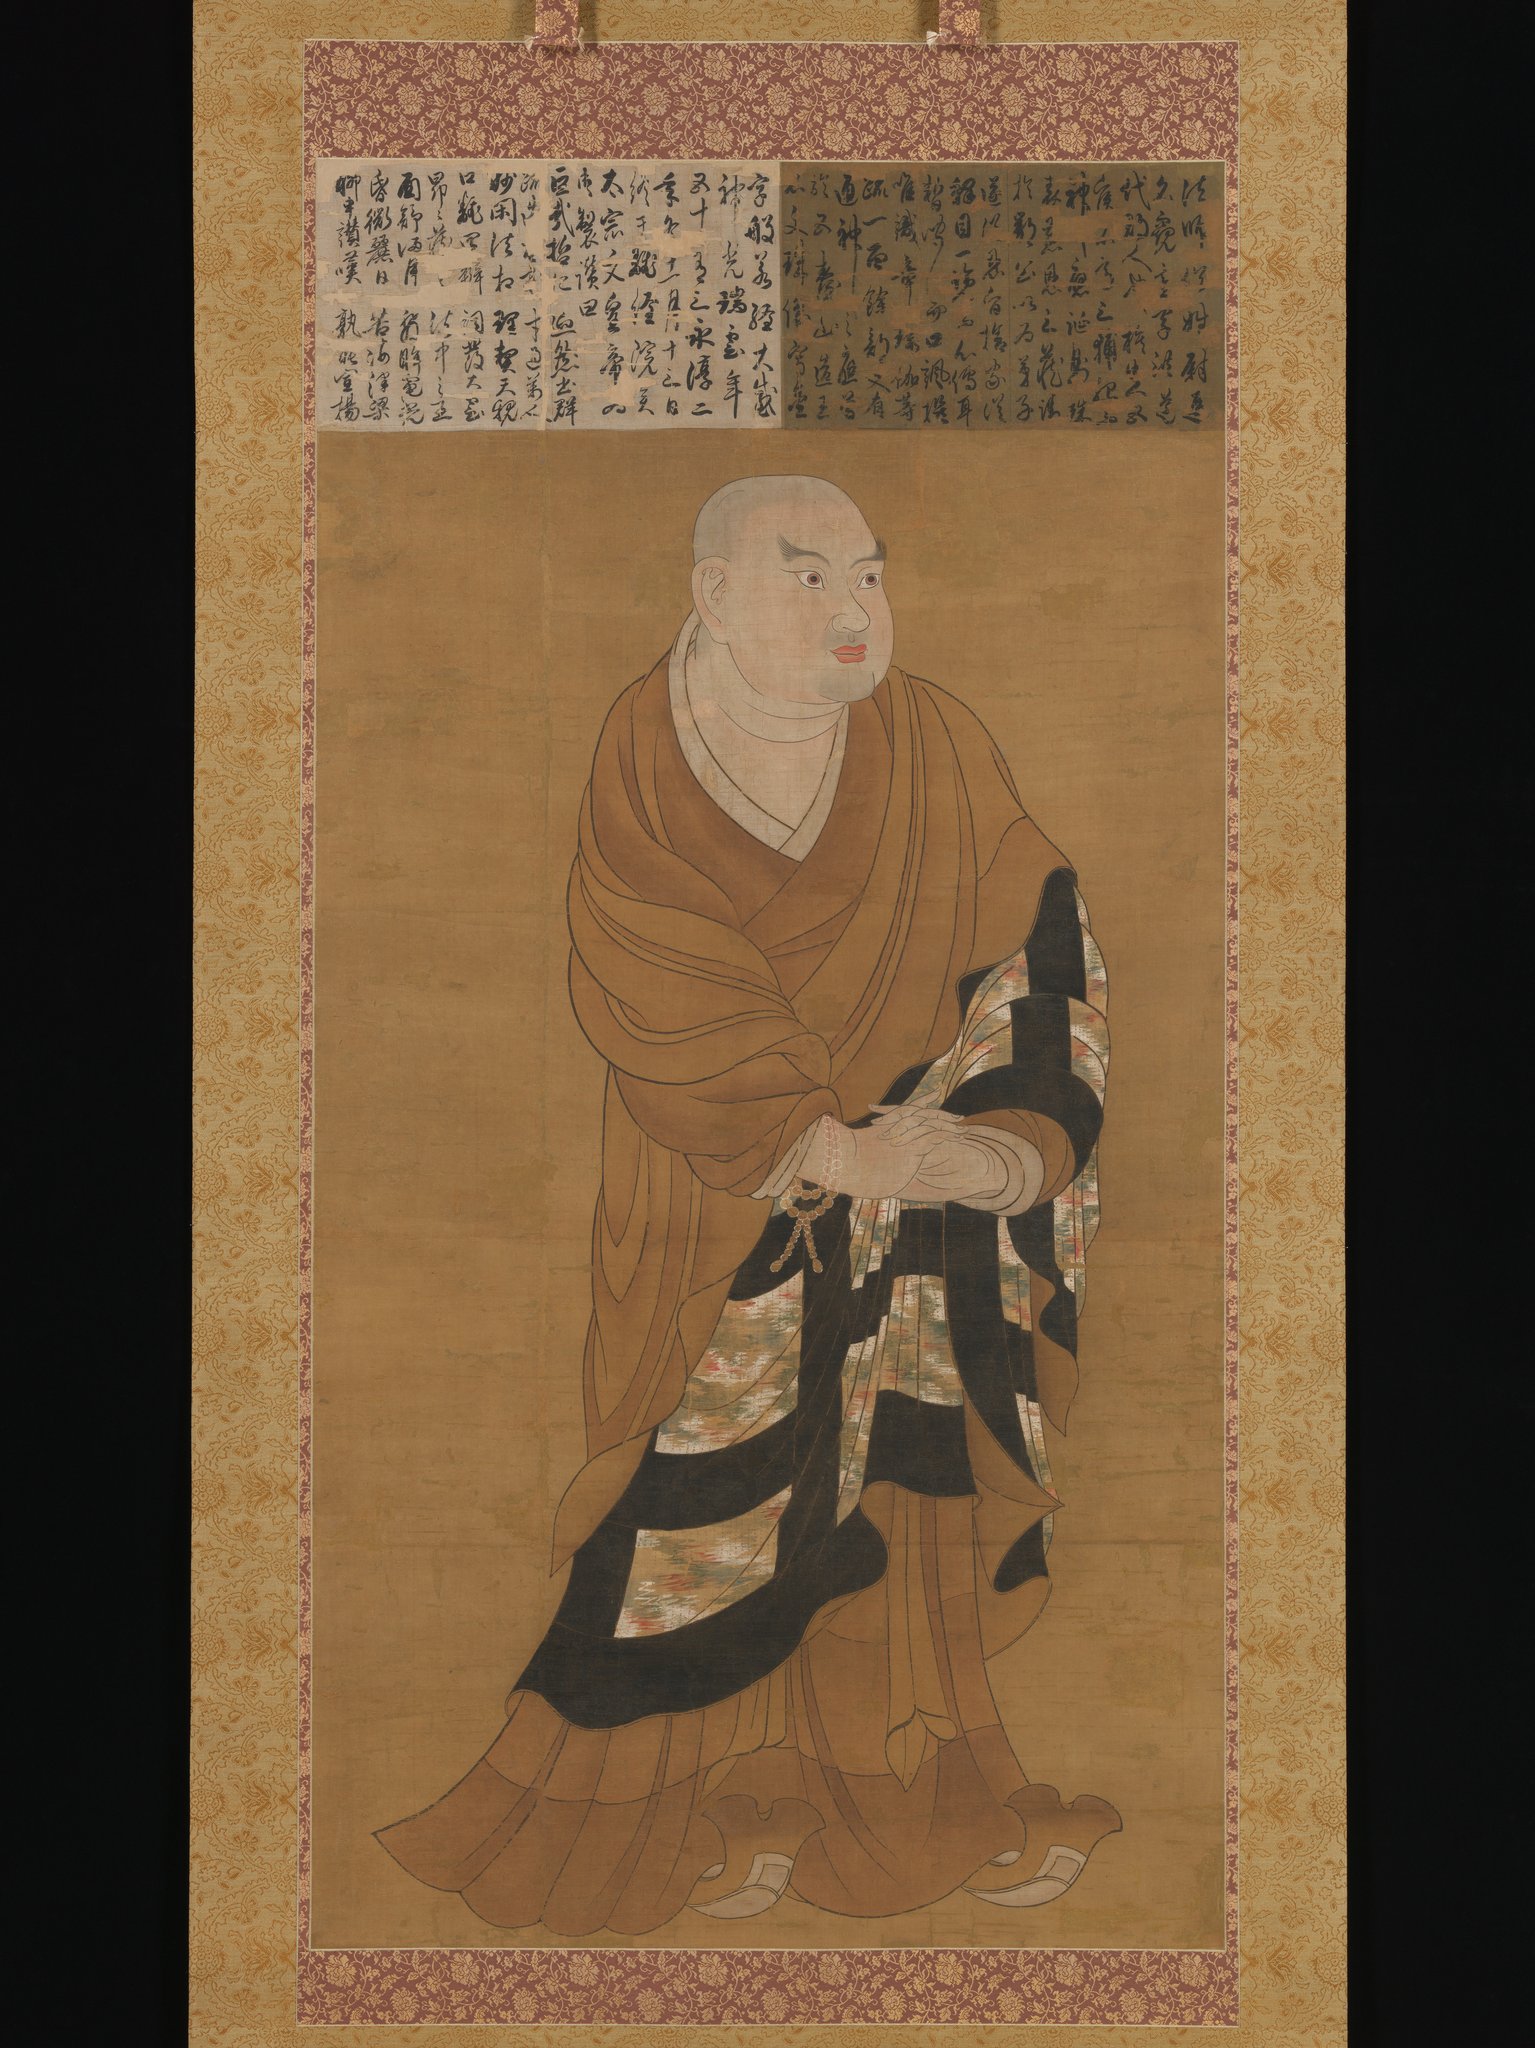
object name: hanging scroll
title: Portrait of Jion Daishi (Guiji)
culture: japanese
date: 1301-1400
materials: ink, silk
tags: buddhism,monks